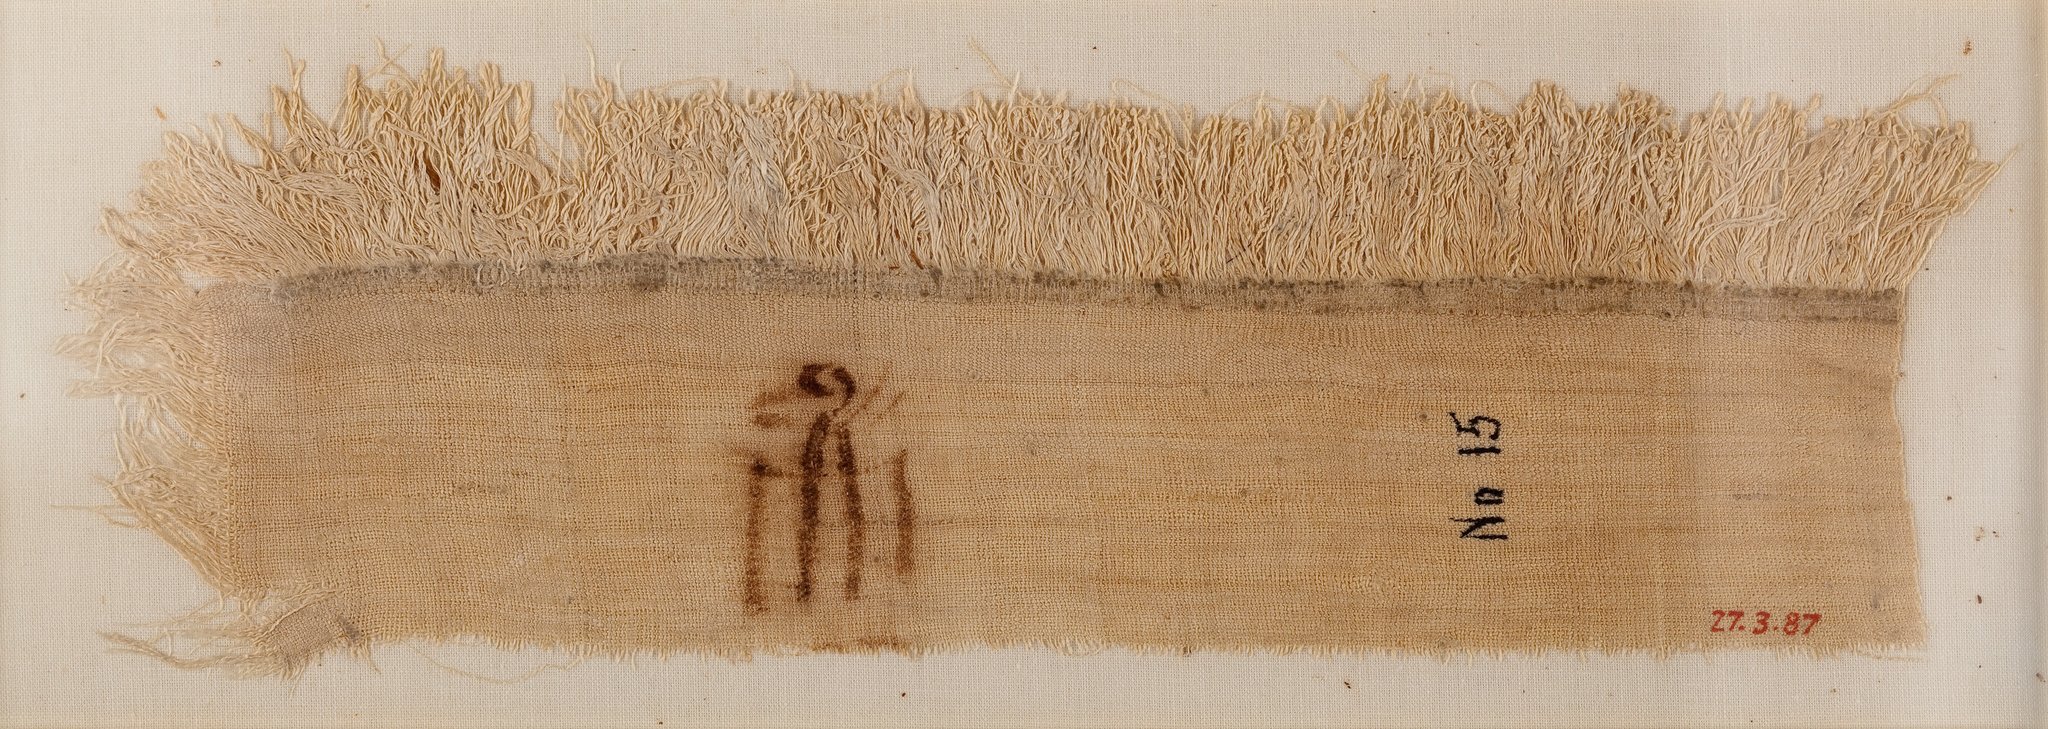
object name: linen mark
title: Linen Mark (Type IV)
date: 1961-1917 BCE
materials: linen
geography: egypt